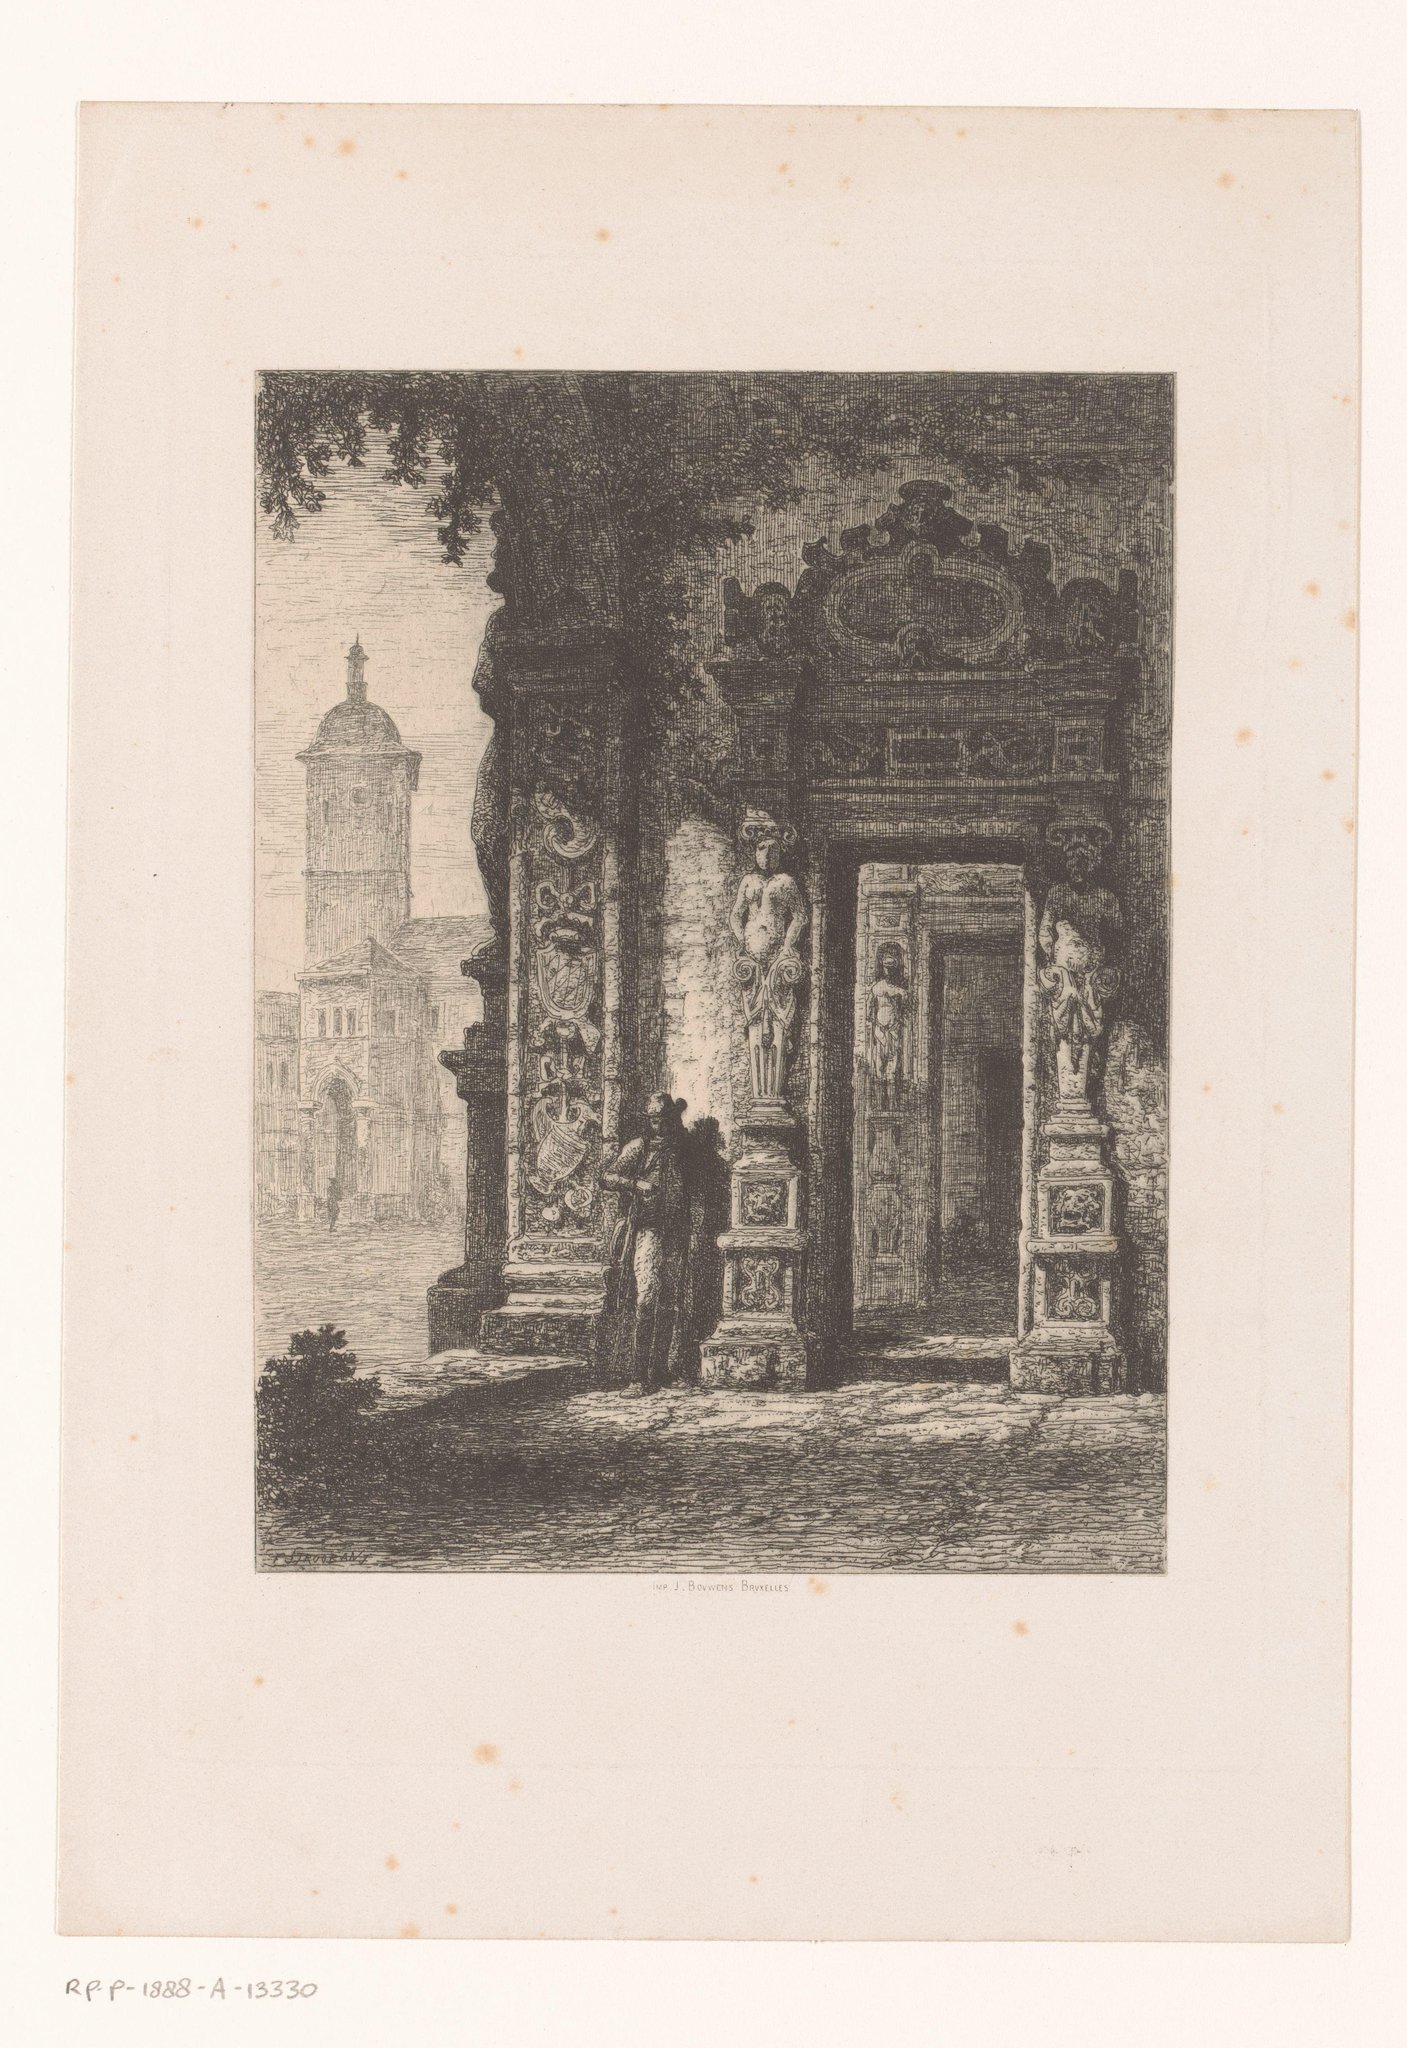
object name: print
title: Man met hoed bij een monumentale poort, links op de achtergrond een toren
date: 1829-1888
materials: paper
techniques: etching, intaglio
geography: brussels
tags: monumental door, porch, 'aediculum', city-view in general; 'veduta', adult man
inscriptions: collector's mark: Lugt 2228